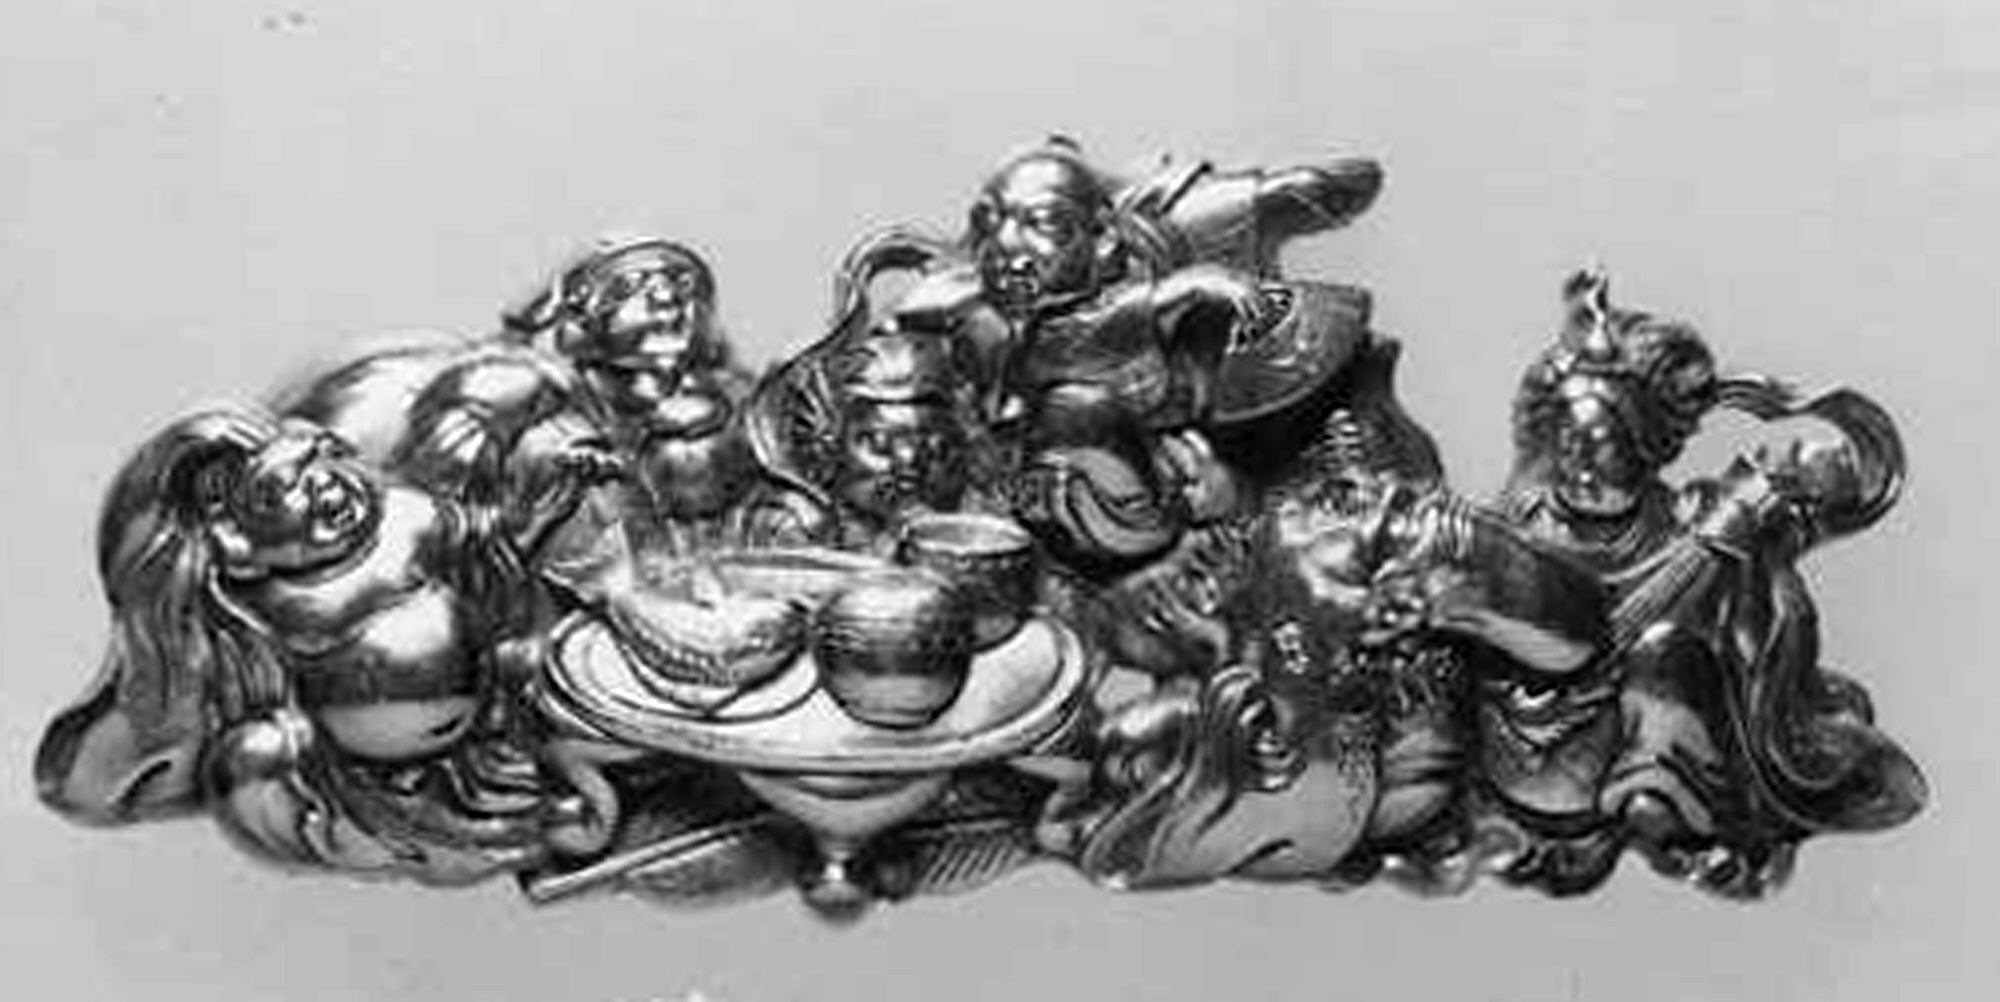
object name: ornament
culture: japanese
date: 1801-1900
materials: gold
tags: men